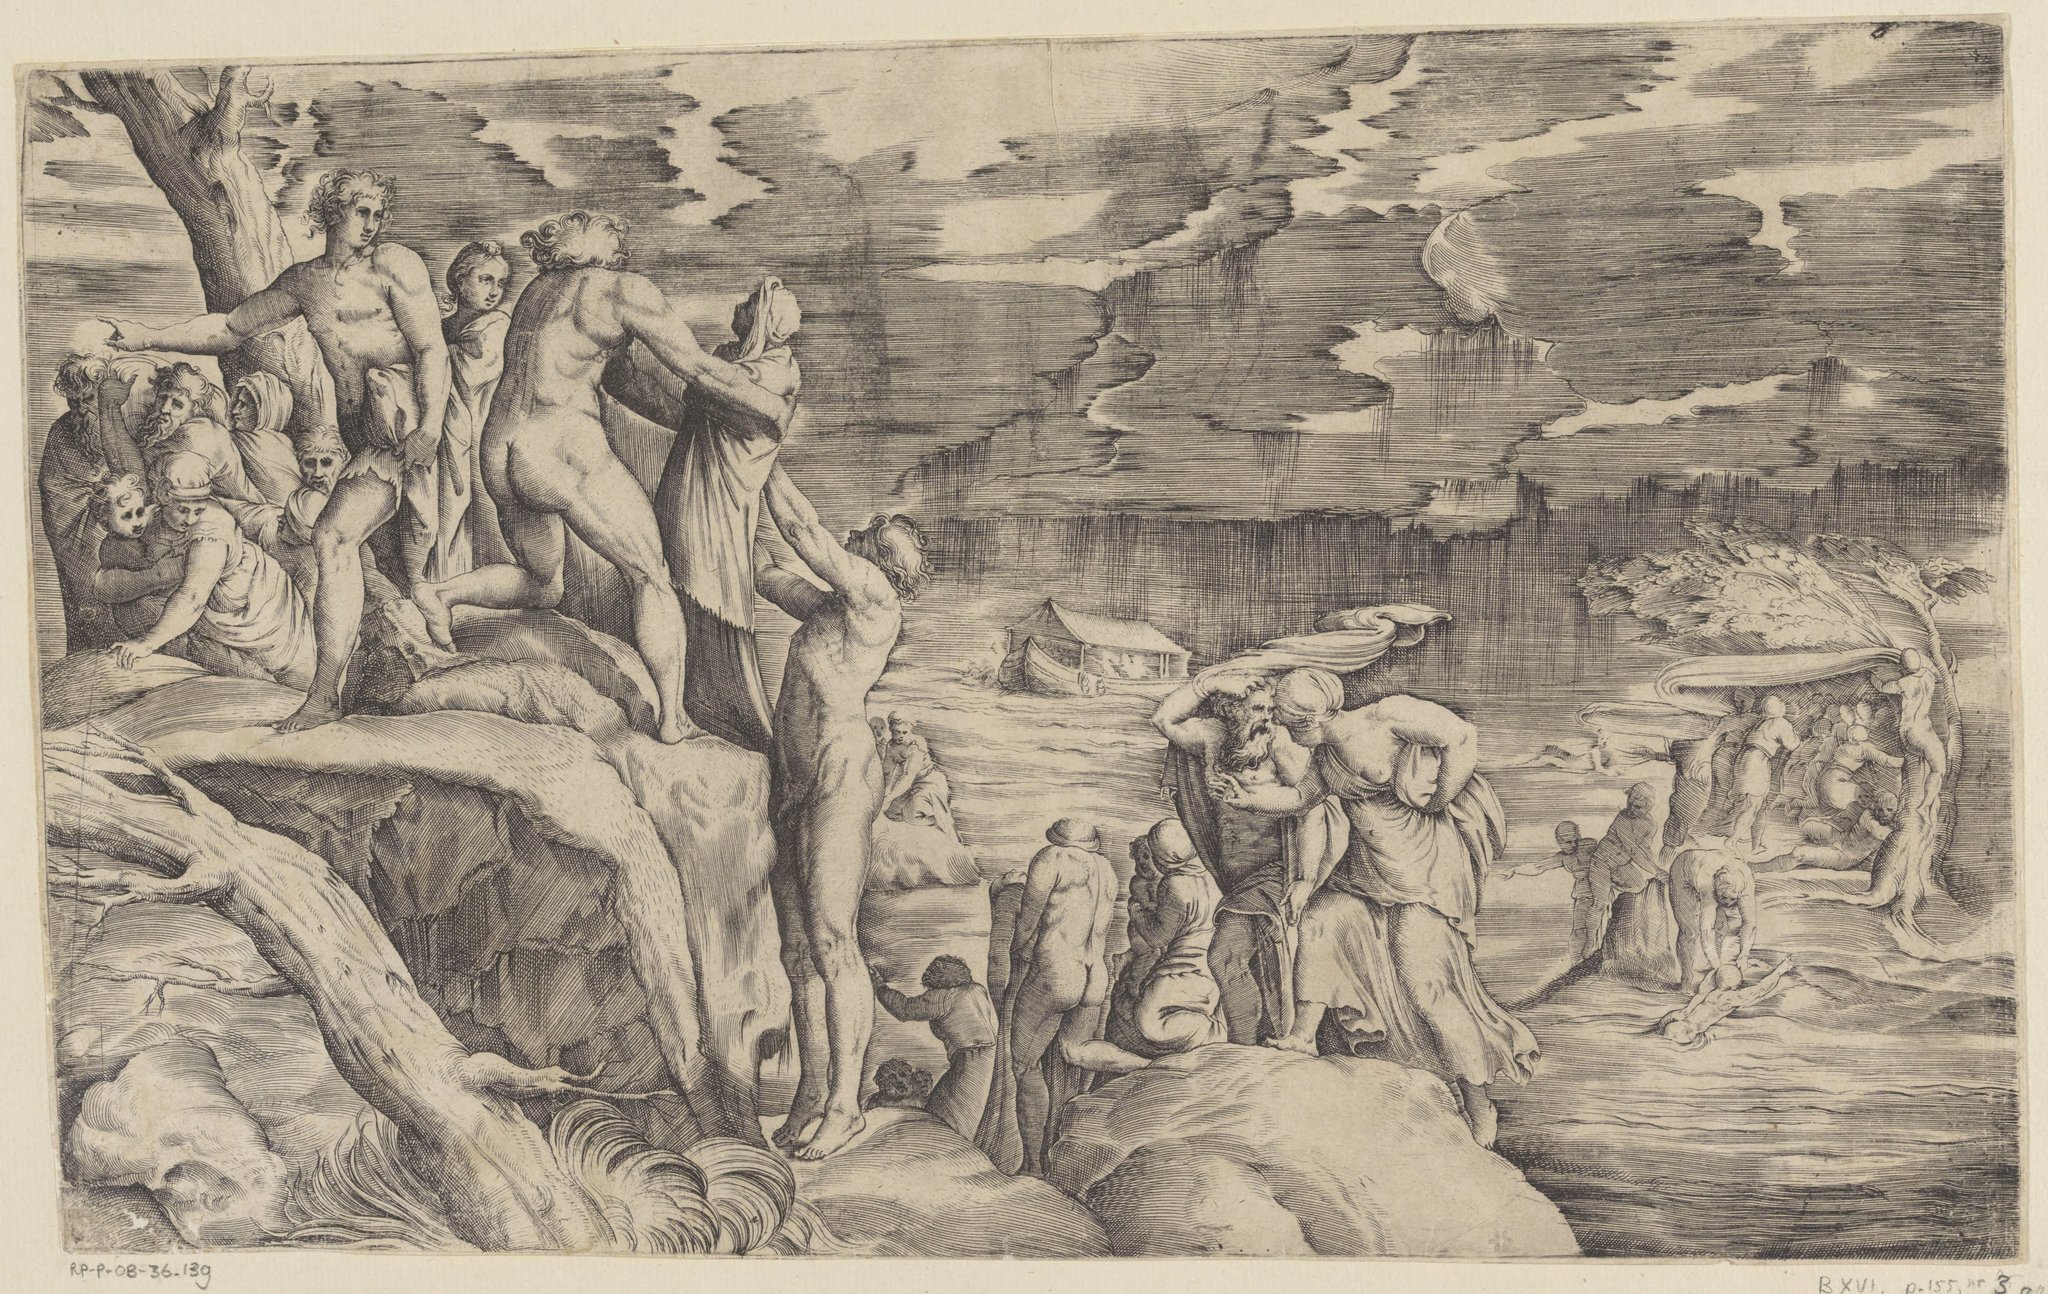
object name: print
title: De Zondvloed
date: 1520-1561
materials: paper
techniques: engraving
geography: italy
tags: the flood and destruction of mankind ~ story of noah (genesis 7:10 - 8:17)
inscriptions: collector's mark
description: De Zondvloed. Mensen vluchten voor het stijgende water. Op de achtergrond de Ark van Noach.